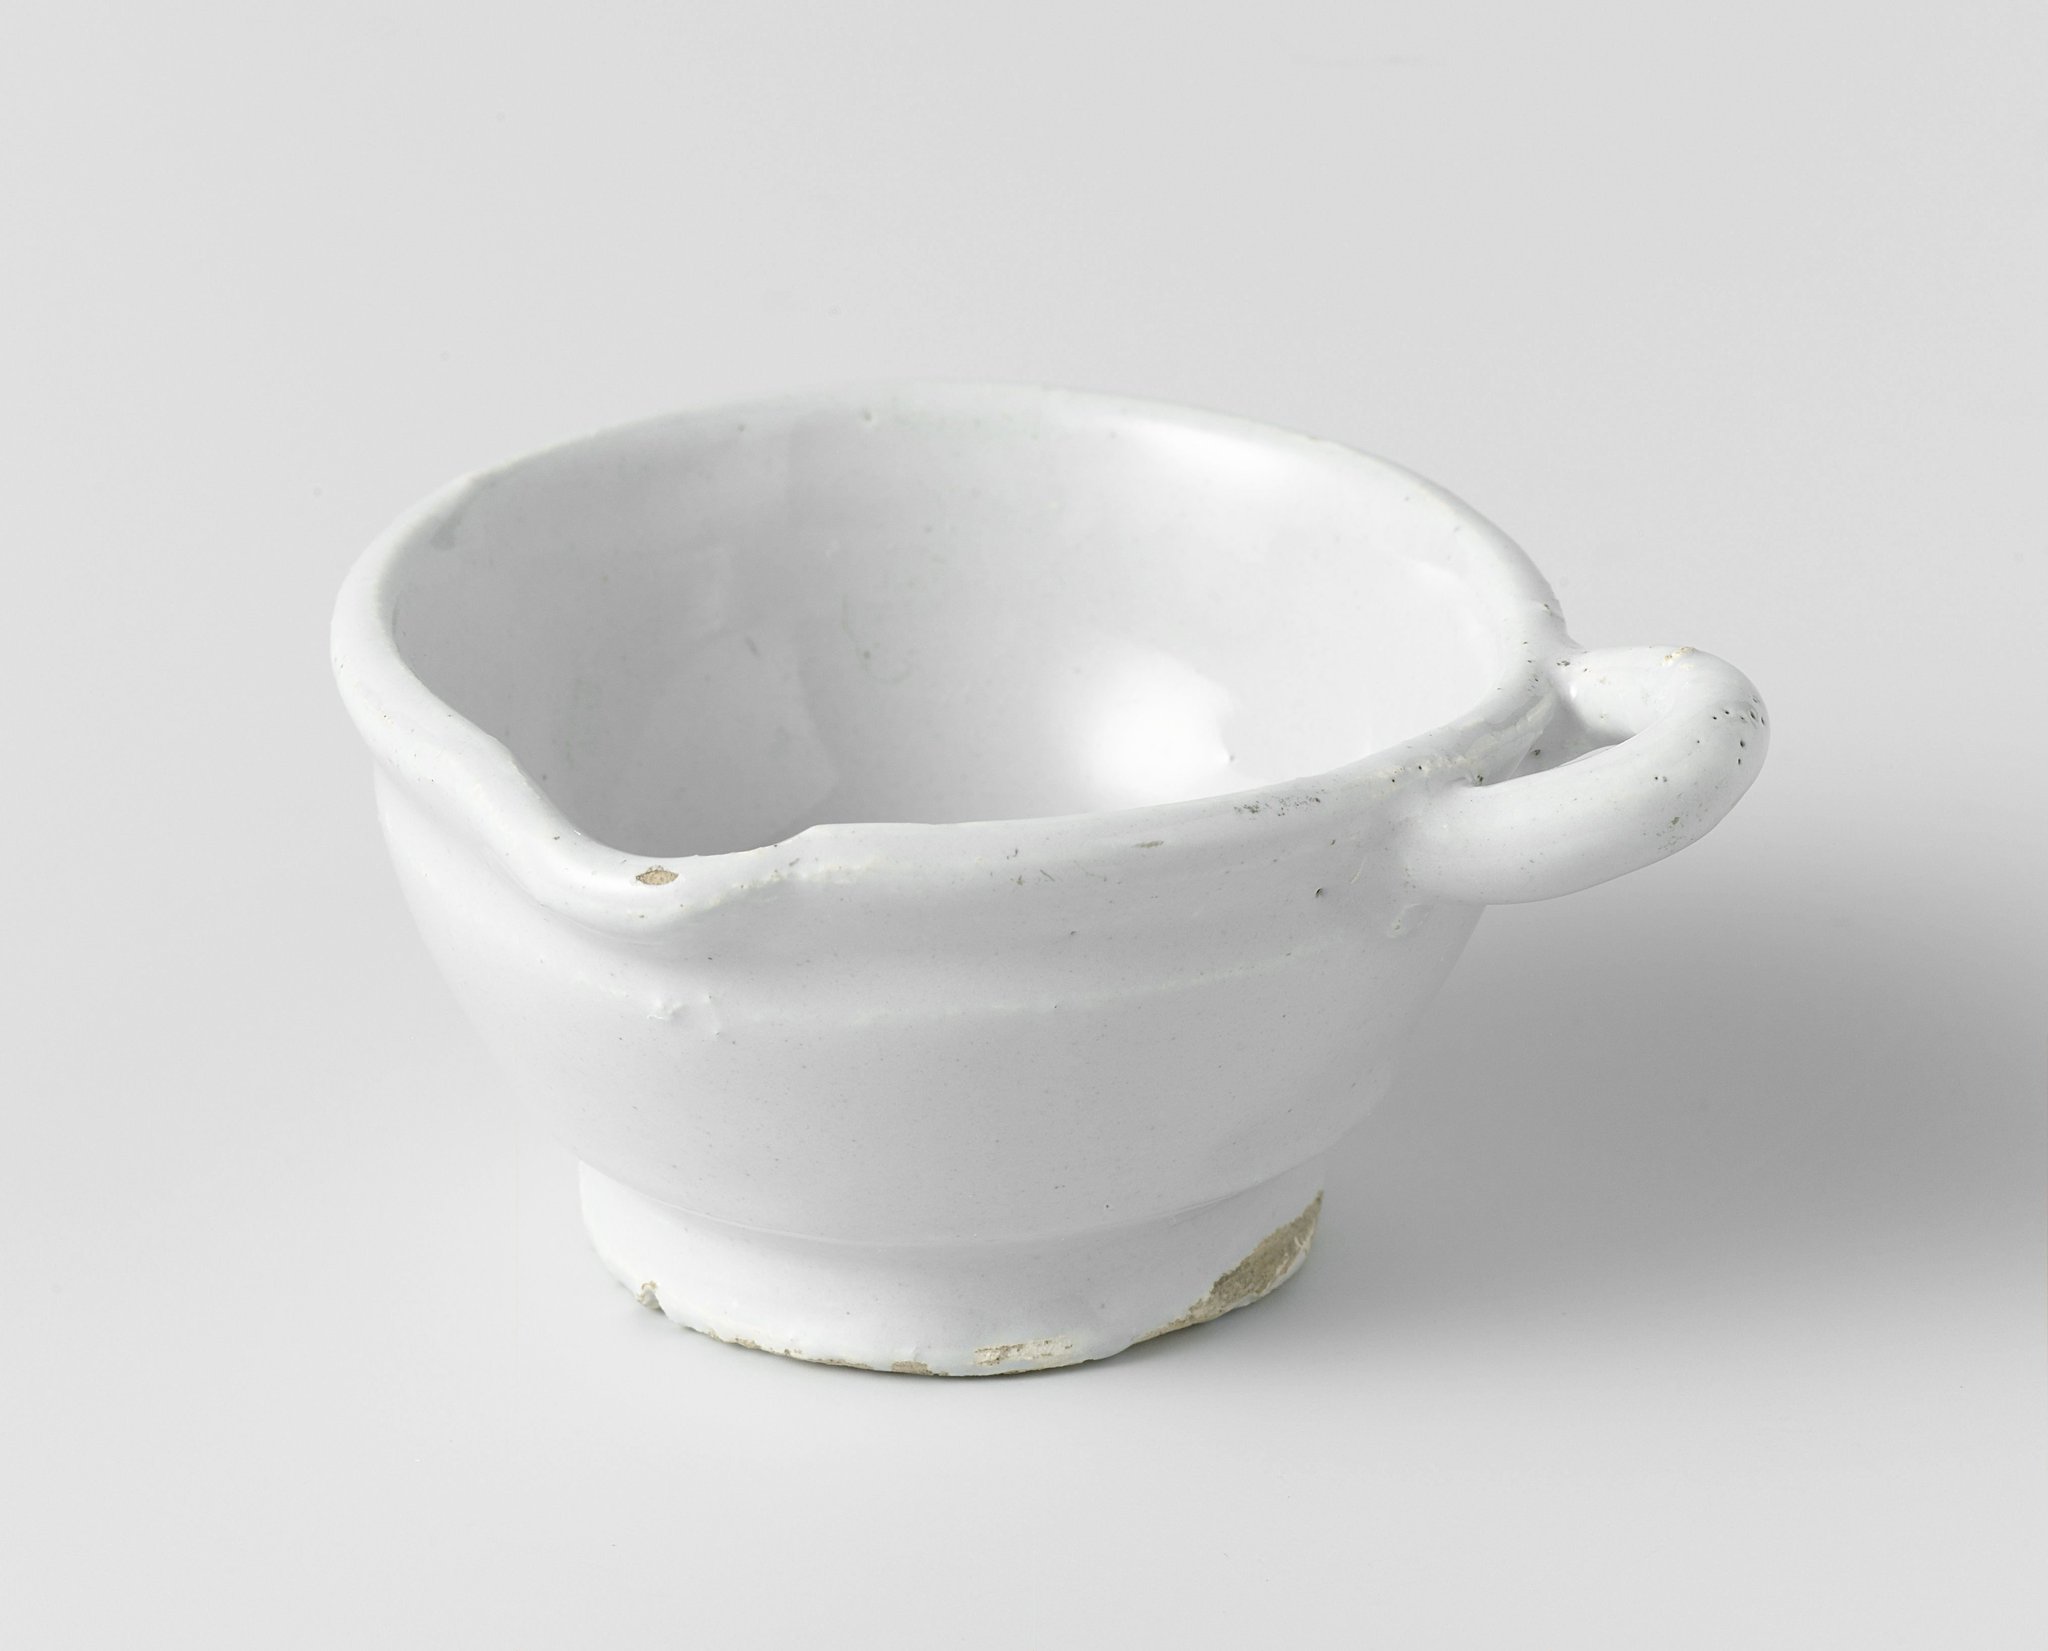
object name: miniature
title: Schenkkom met witte glazuur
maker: Anonymous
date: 1700-1799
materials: earthenware, glaze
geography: delft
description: Schenkkom of oorkom van wit geglazuurd aardewerk met oor en schenktuit.